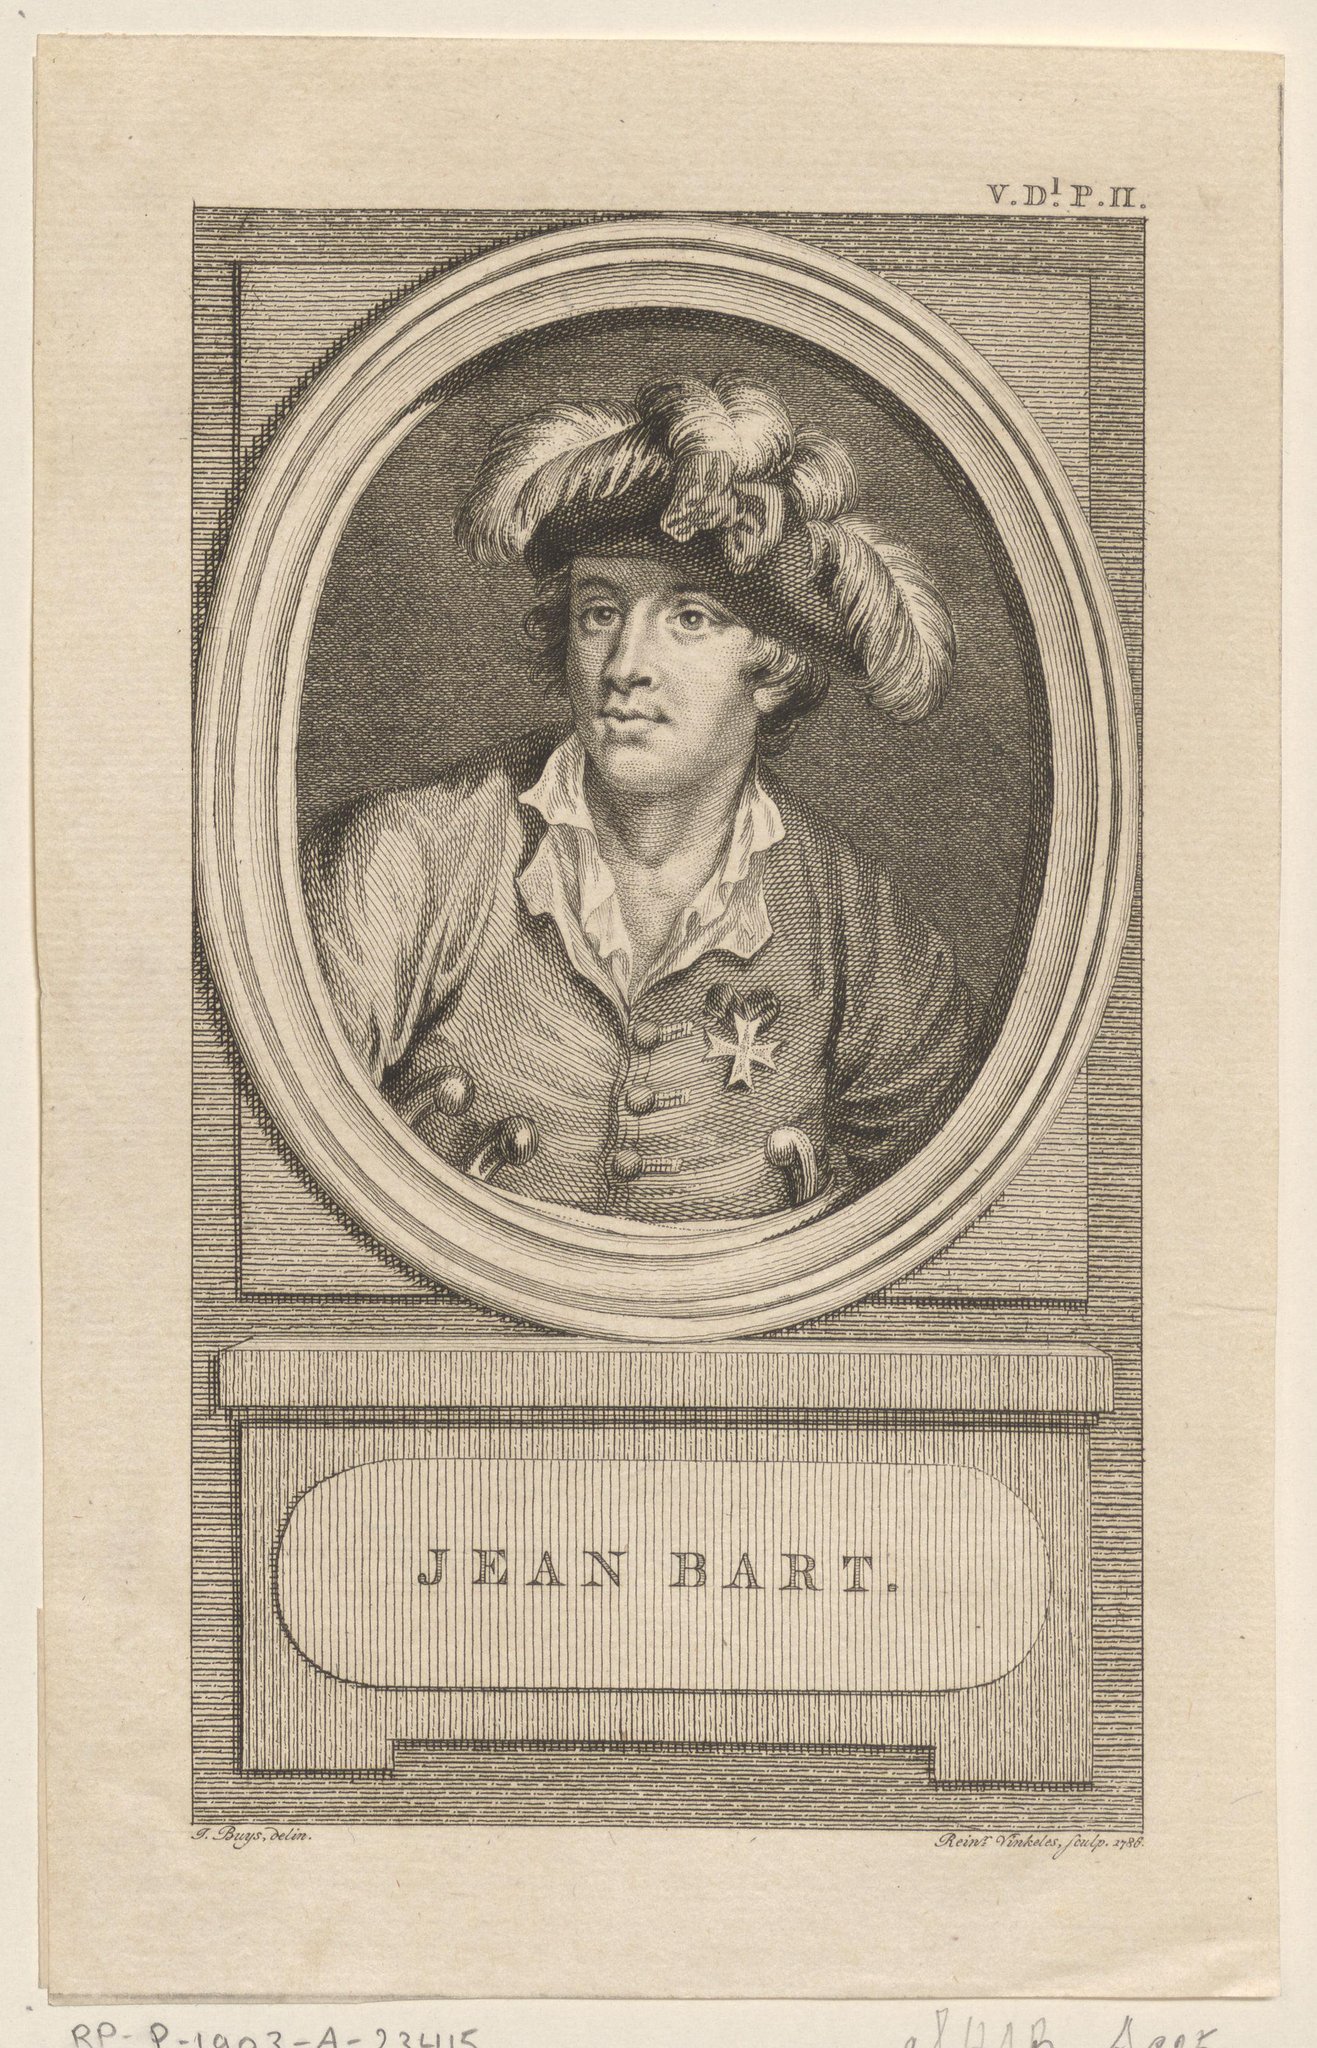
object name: print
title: Portret van Jan Bart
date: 1786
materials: paper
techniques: engraving, etching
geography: amsterdam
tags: historical persons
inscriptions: collector's mark: Lugt 2228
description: Prent uit: Kok, Jacobus. Vaderlandsch woordenboek: met kaarten, plaaten en pourtraitten. Amsterdam: Johannes Allart, 1785-1796, dl. 5.